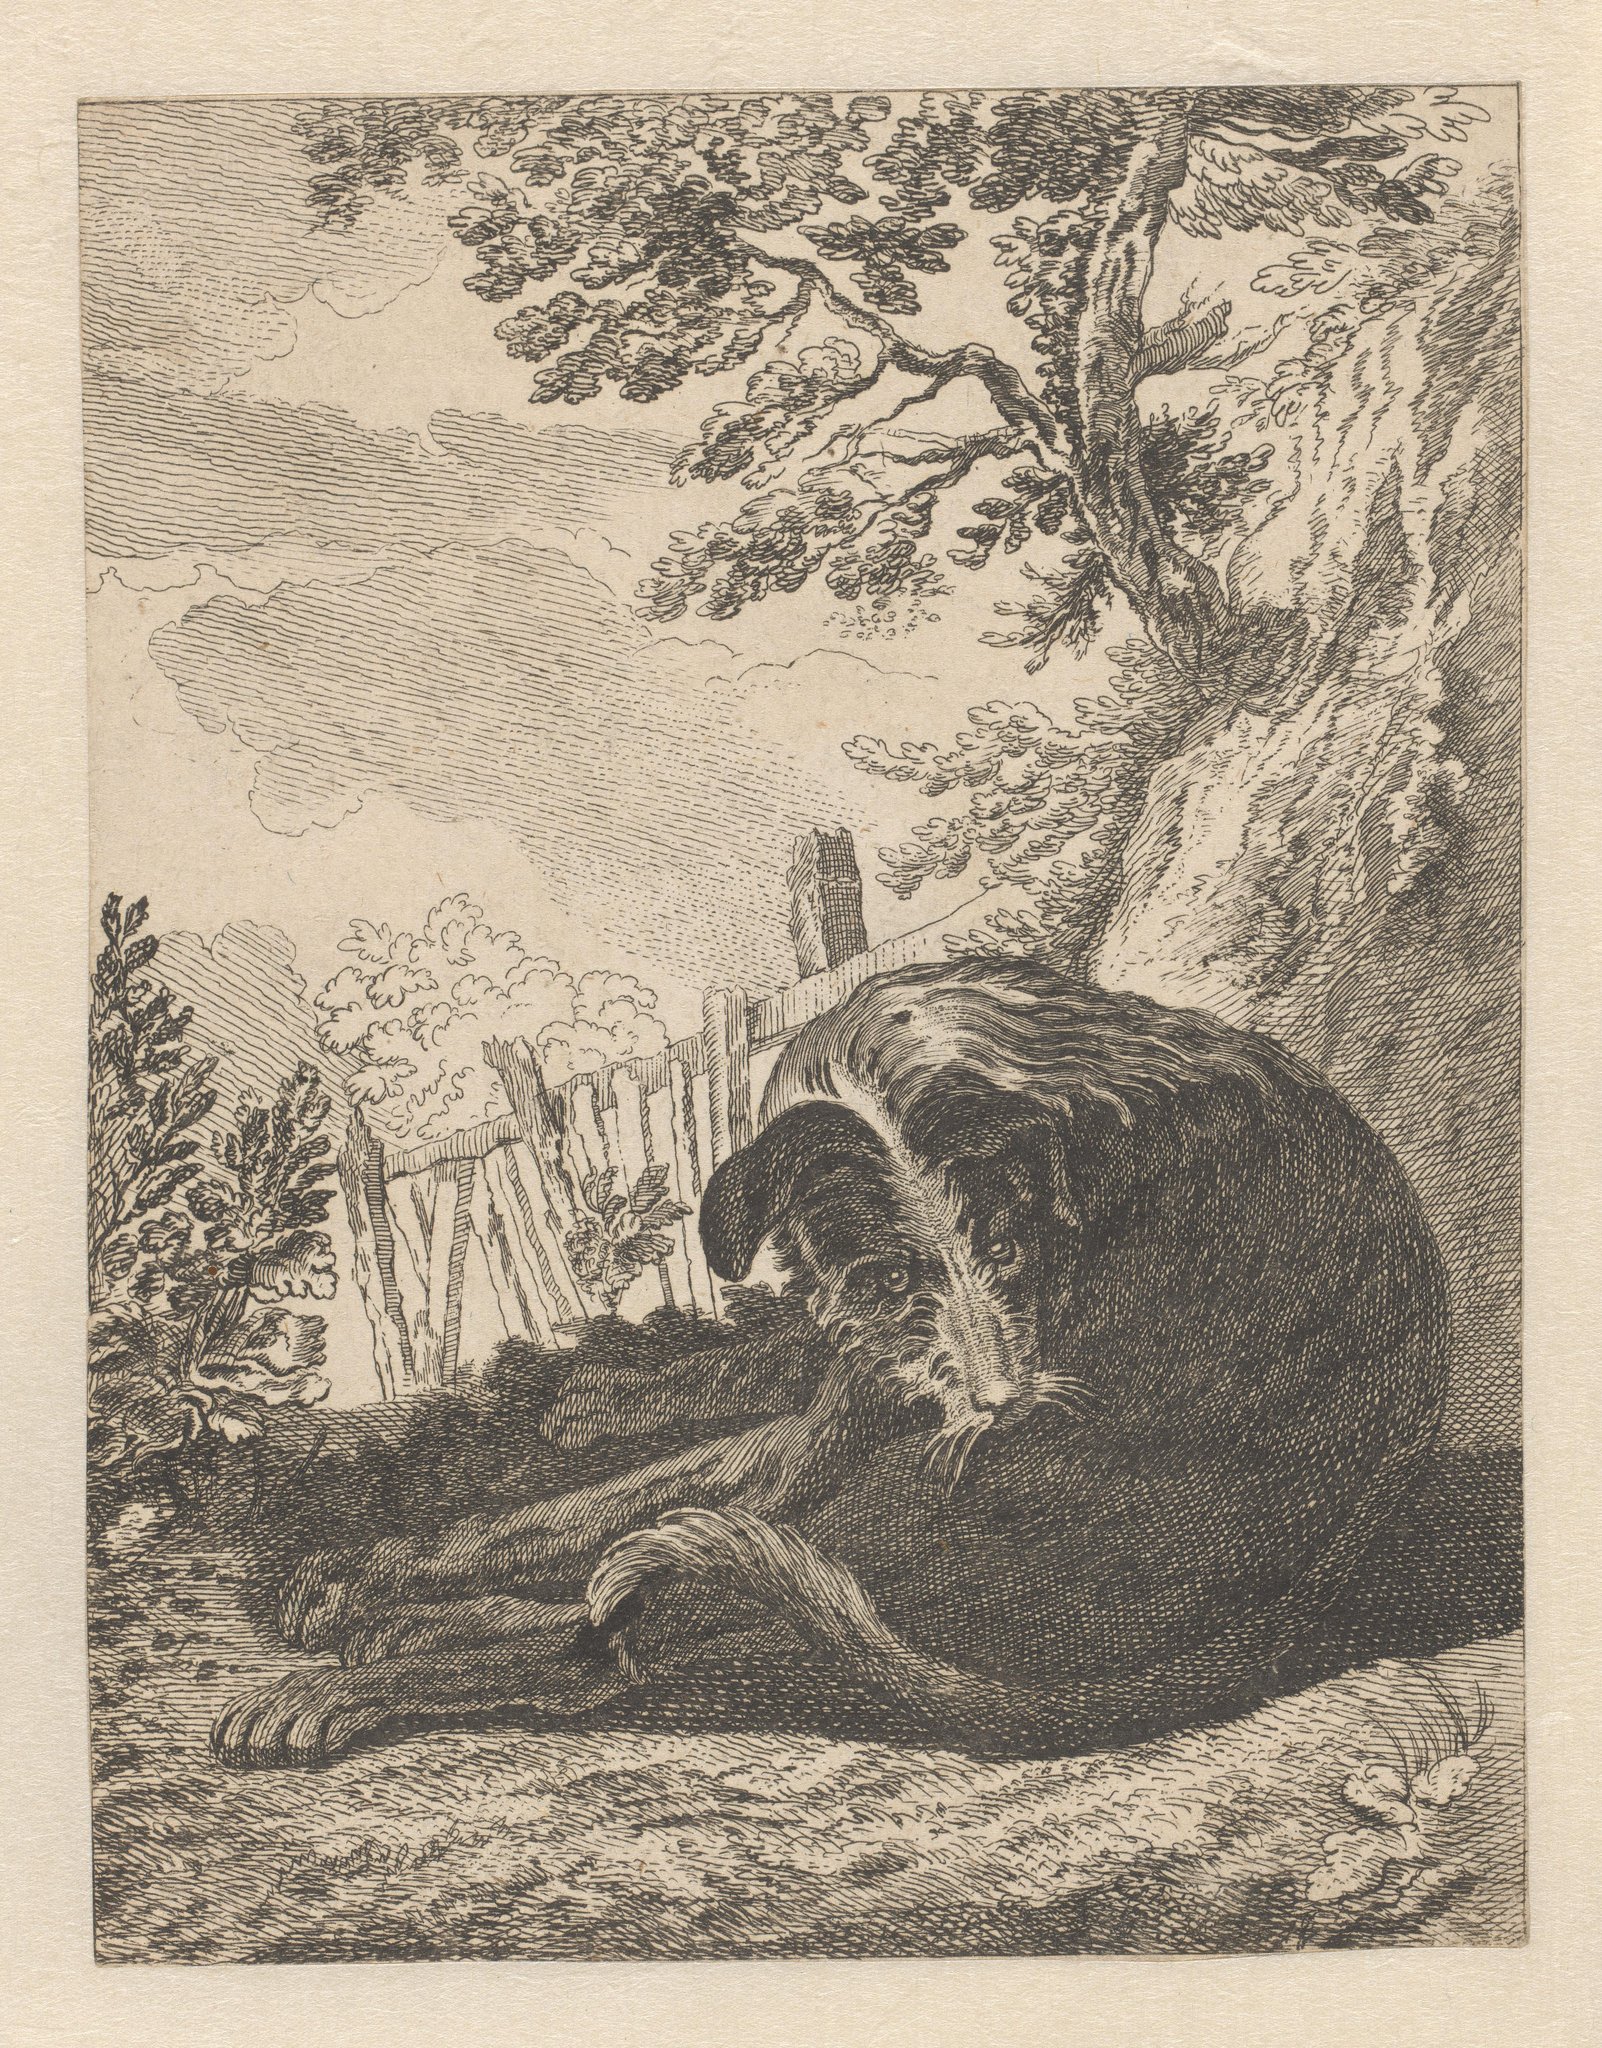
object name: print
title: Zittende hond die zijn achterflank schoonlikt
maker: jan dasveldt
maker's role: draughtsman, print maker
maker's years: 1770-1855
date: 1780-1850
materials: paper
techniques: etching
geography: amsterdam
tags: dog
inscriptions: collector's mark: Lugt 2760, collector's mark: Lugt 2228